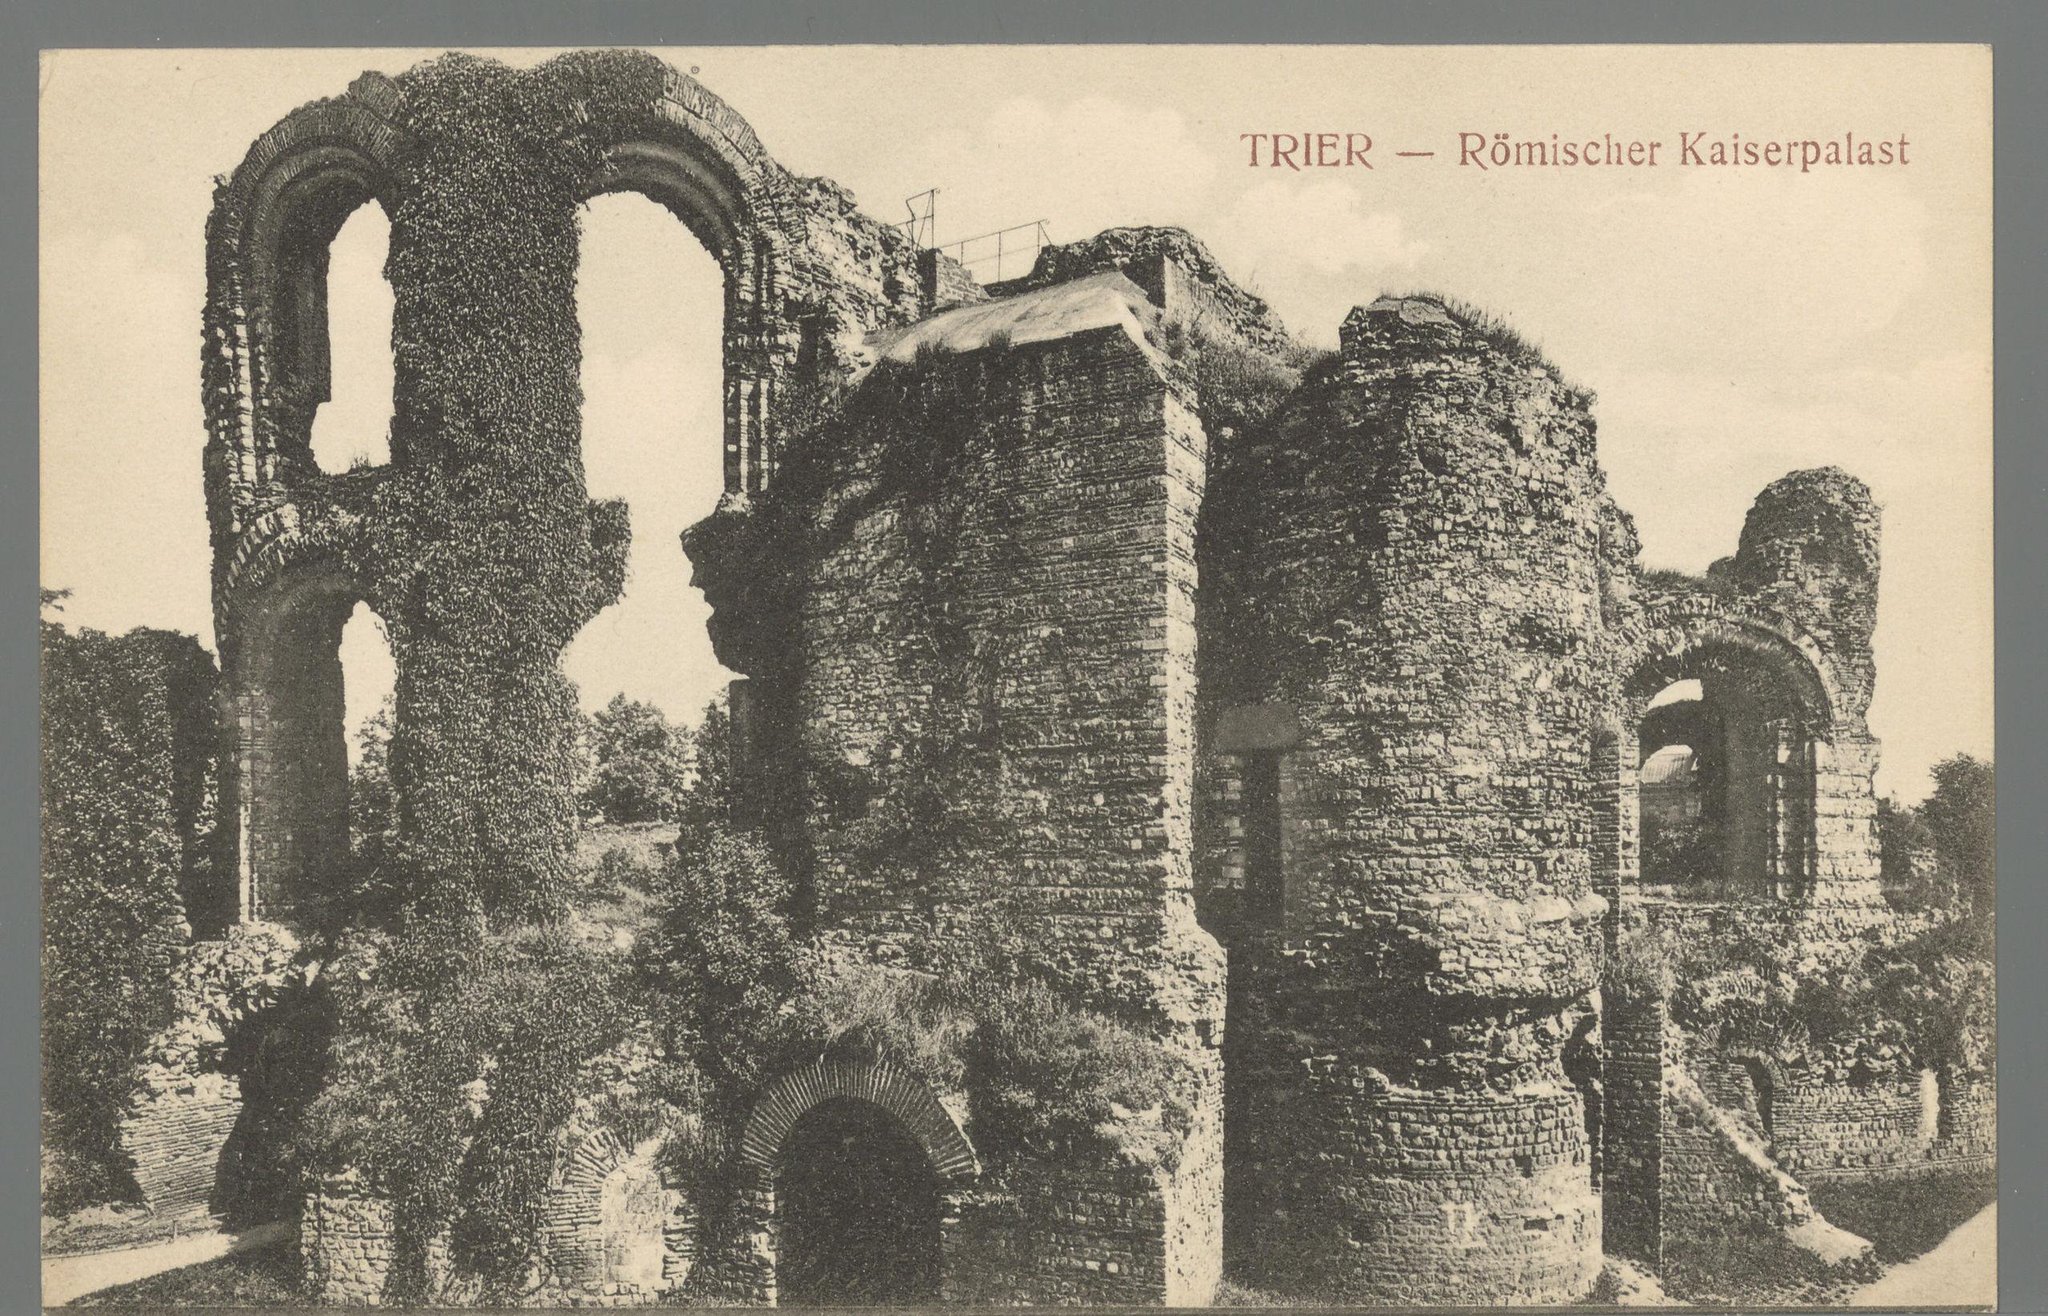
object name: ansichtkaart, prentbriefkaart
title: Trier - Römischer Kaiserpalast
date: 1905-1930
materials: cardboard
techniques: photograph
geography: trier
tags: watering-place, spa